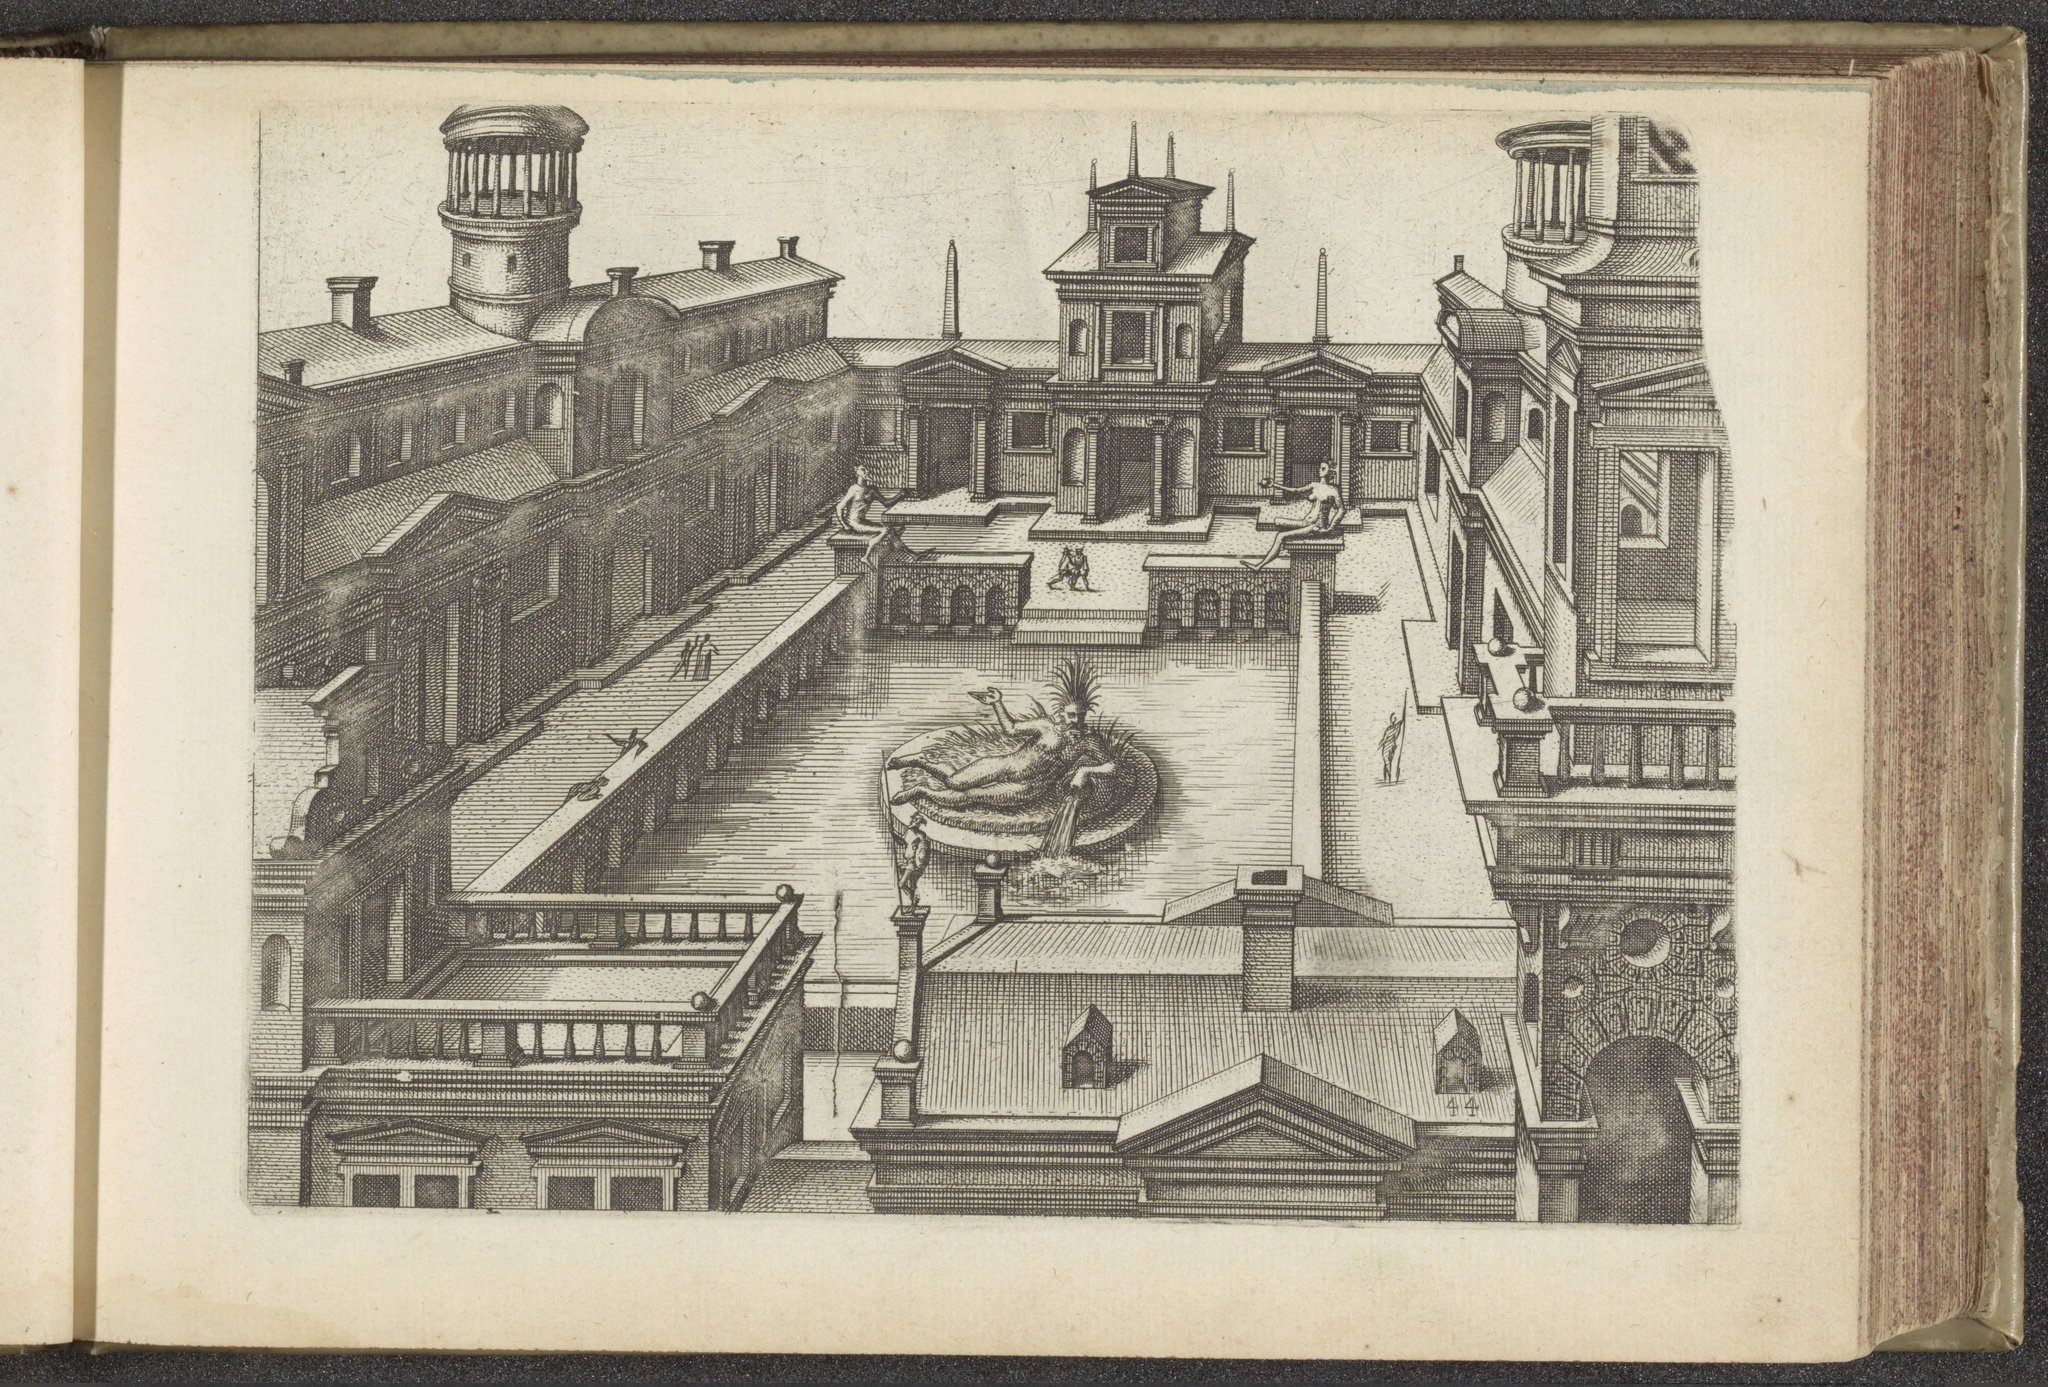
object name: print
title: Binnenplaats met een beeld van een riviergod in een rechthoekige vijver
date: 1562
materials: paper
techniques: etching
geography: antwerp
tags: architectural representations in general, river-gods, courtyard, garden pond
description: Binnenplaats met een beeld van een riviergod in een rechthoekige vijver. Deze prent maakt deel uit van een album.